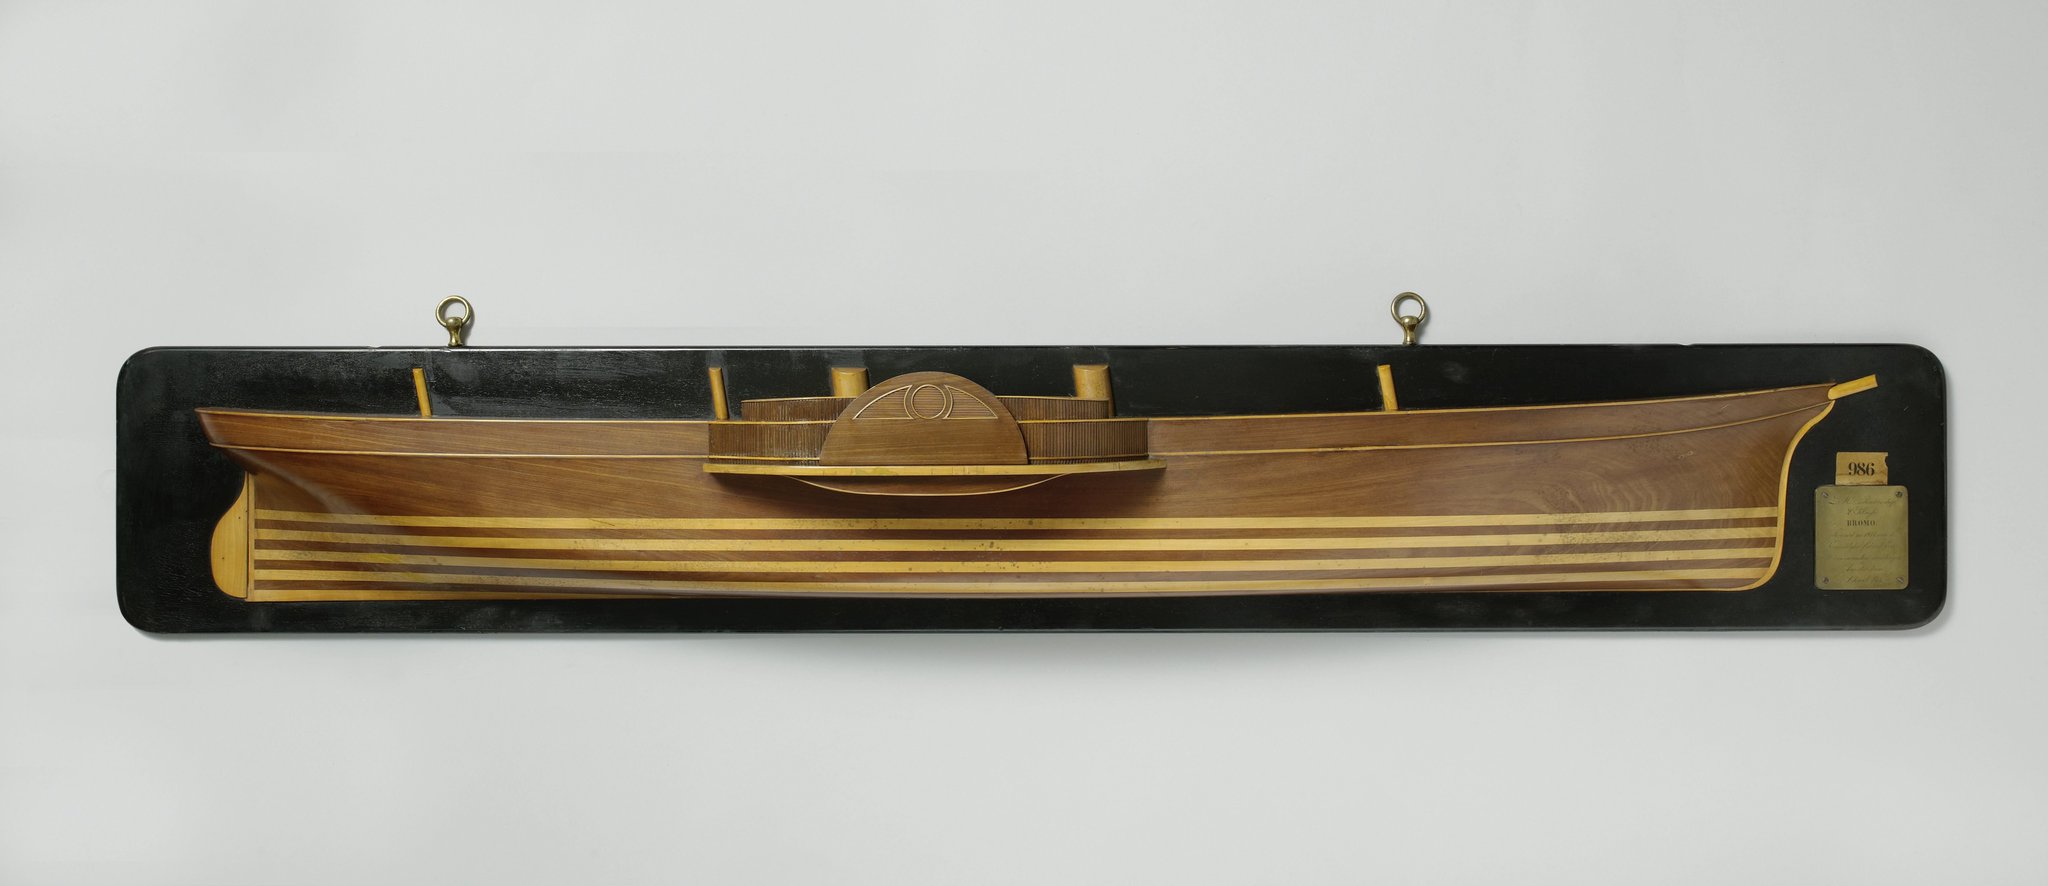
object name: half model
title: Half Model of a Paddle Steamer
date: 1873-1874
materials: brass, wood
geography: amsterdam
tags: bromo (schip)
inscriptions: label, centre right: ‘986’ former inventory label, inscription, bottom right, on a rectangular brass label: ‘Z.M. Raderschip / 2e Klasse / BROMO. / gebouwd in 1874 aan de / Koninklijke fabriek van / Stoom en andere werktuigen / te / Amsterdam. / Schaal 1/40.’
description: Het raderstoomschip 2de klasse van 6 stukken Bromo, lang 60 m, werd gebouwd bij de Koninklijke Fabriek voor Stoom- en andere Werktuigen in Amsterdam in 1873-1874. Gebouwd van ijzer bekleed met hout. Het schip deed enkel in Oost-Indië dienst, tot haar verkoop in Soerabaja in 1917.